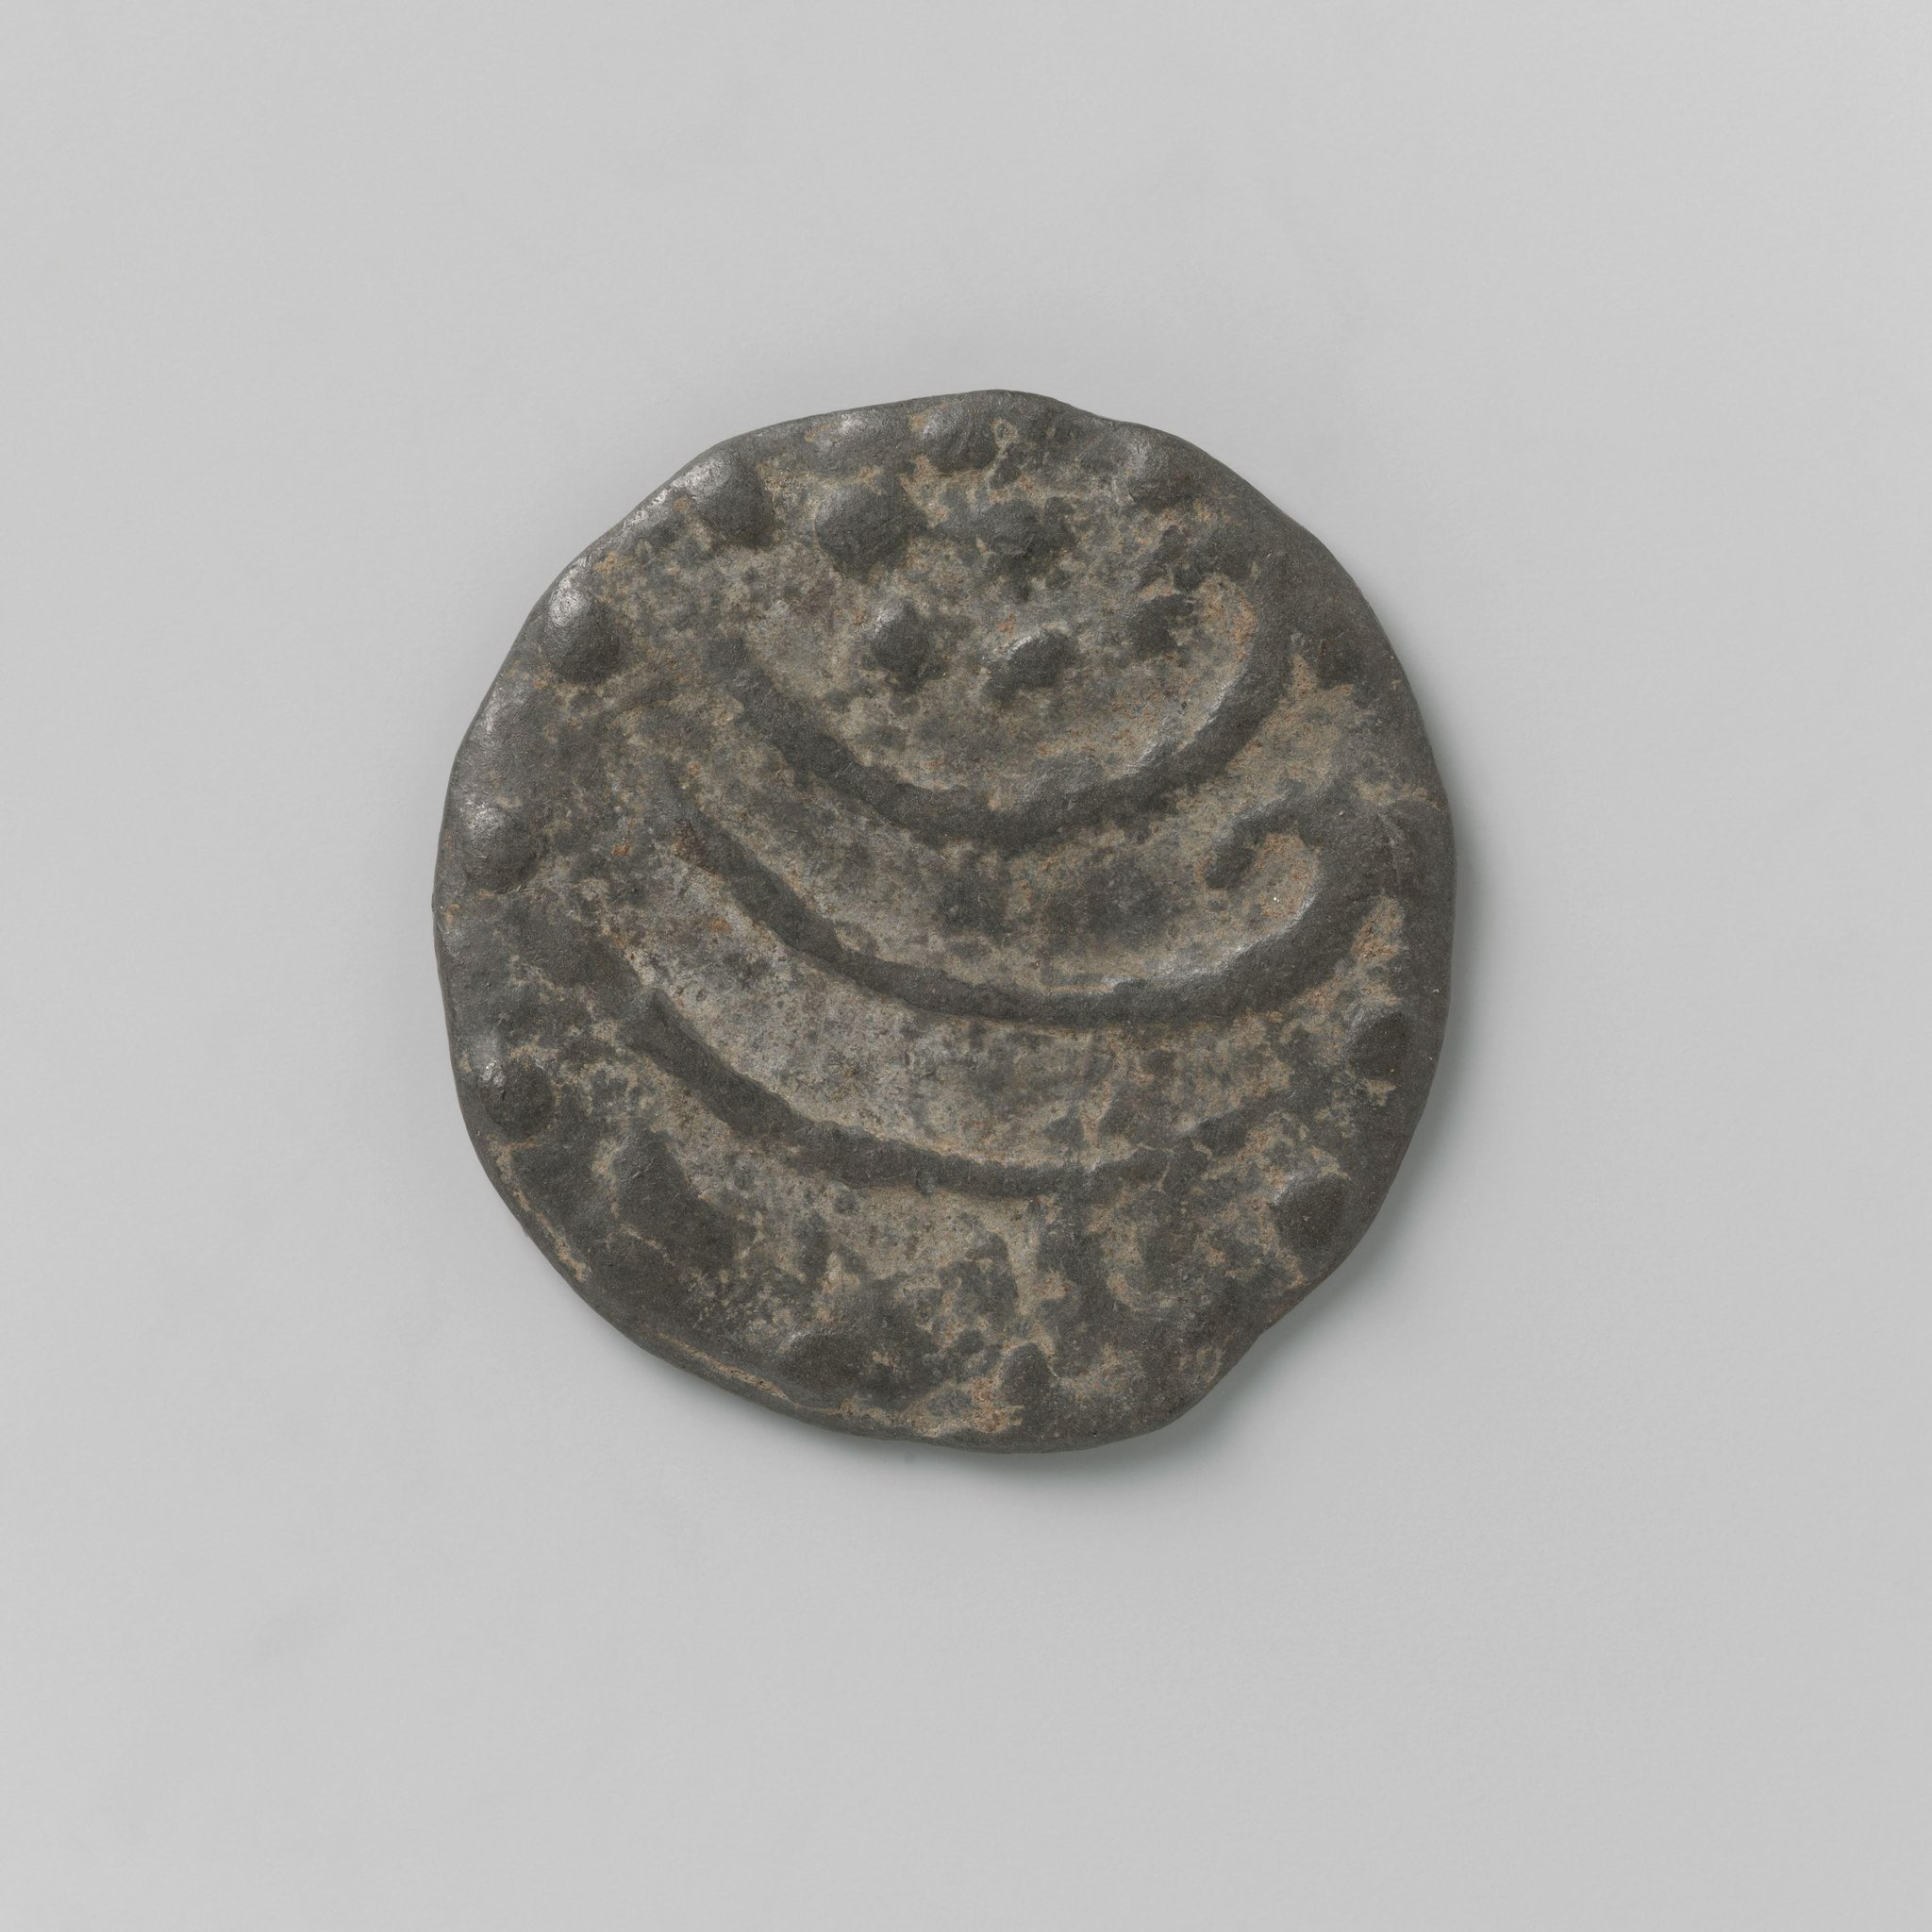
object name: coin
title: Atjeh, Sumatra, sultan Mohammed, kasja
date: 1824-1838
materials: tin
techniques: casting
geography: aceh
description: Tinnen munt. Voorzijde: drieregelig opschrift in Arabische lettertekens. Keerzijde: drieregelig opschrift in Arabische lettertekens, waaronder jaartal in Islamitische jaartelling